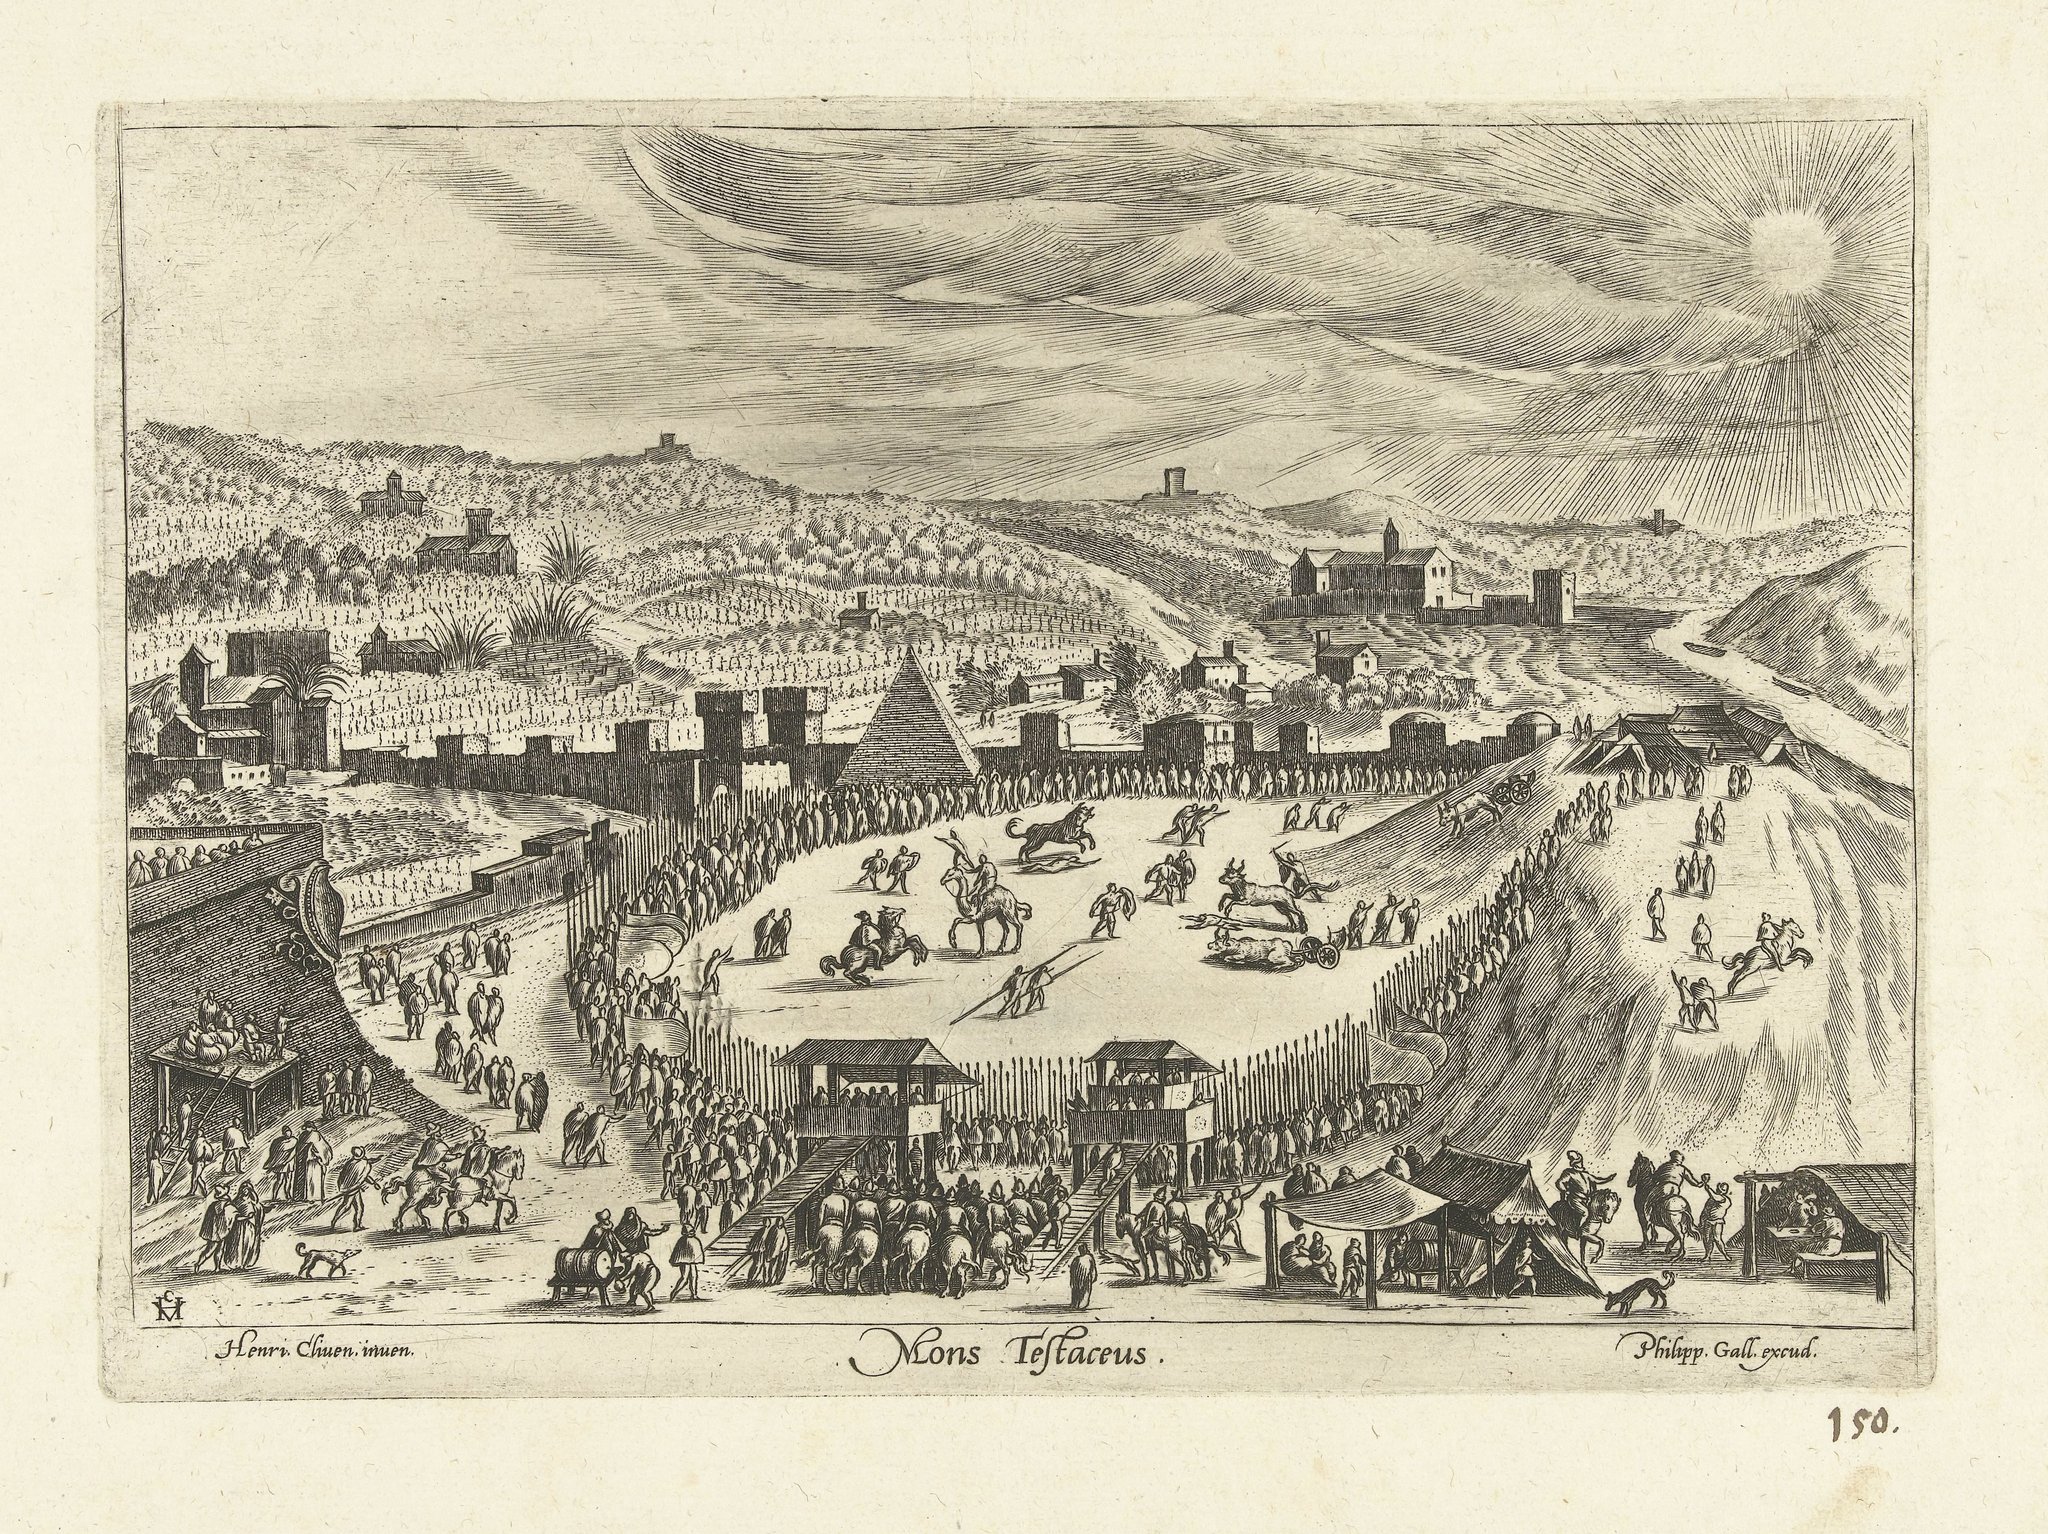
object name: print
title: Gezicht op Monte Testaccio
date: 1585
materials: paper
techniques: engraving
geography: antwerp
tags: joust, tilt, city-view, and landscape with man-made constructions (+ city(-scape) with figures, staffage)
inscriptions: collector's mark: Lugt 2228, number: ‘150’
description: Gezicht op Monte Testaccio. Er is een toernooi aan de gang en heel wat toeschouwers zijn samengestroomd om het spektakel te zien. De prent is deel van een serie die verschillende plaatsen in het Middellandse Zeegebied afbeeldt.